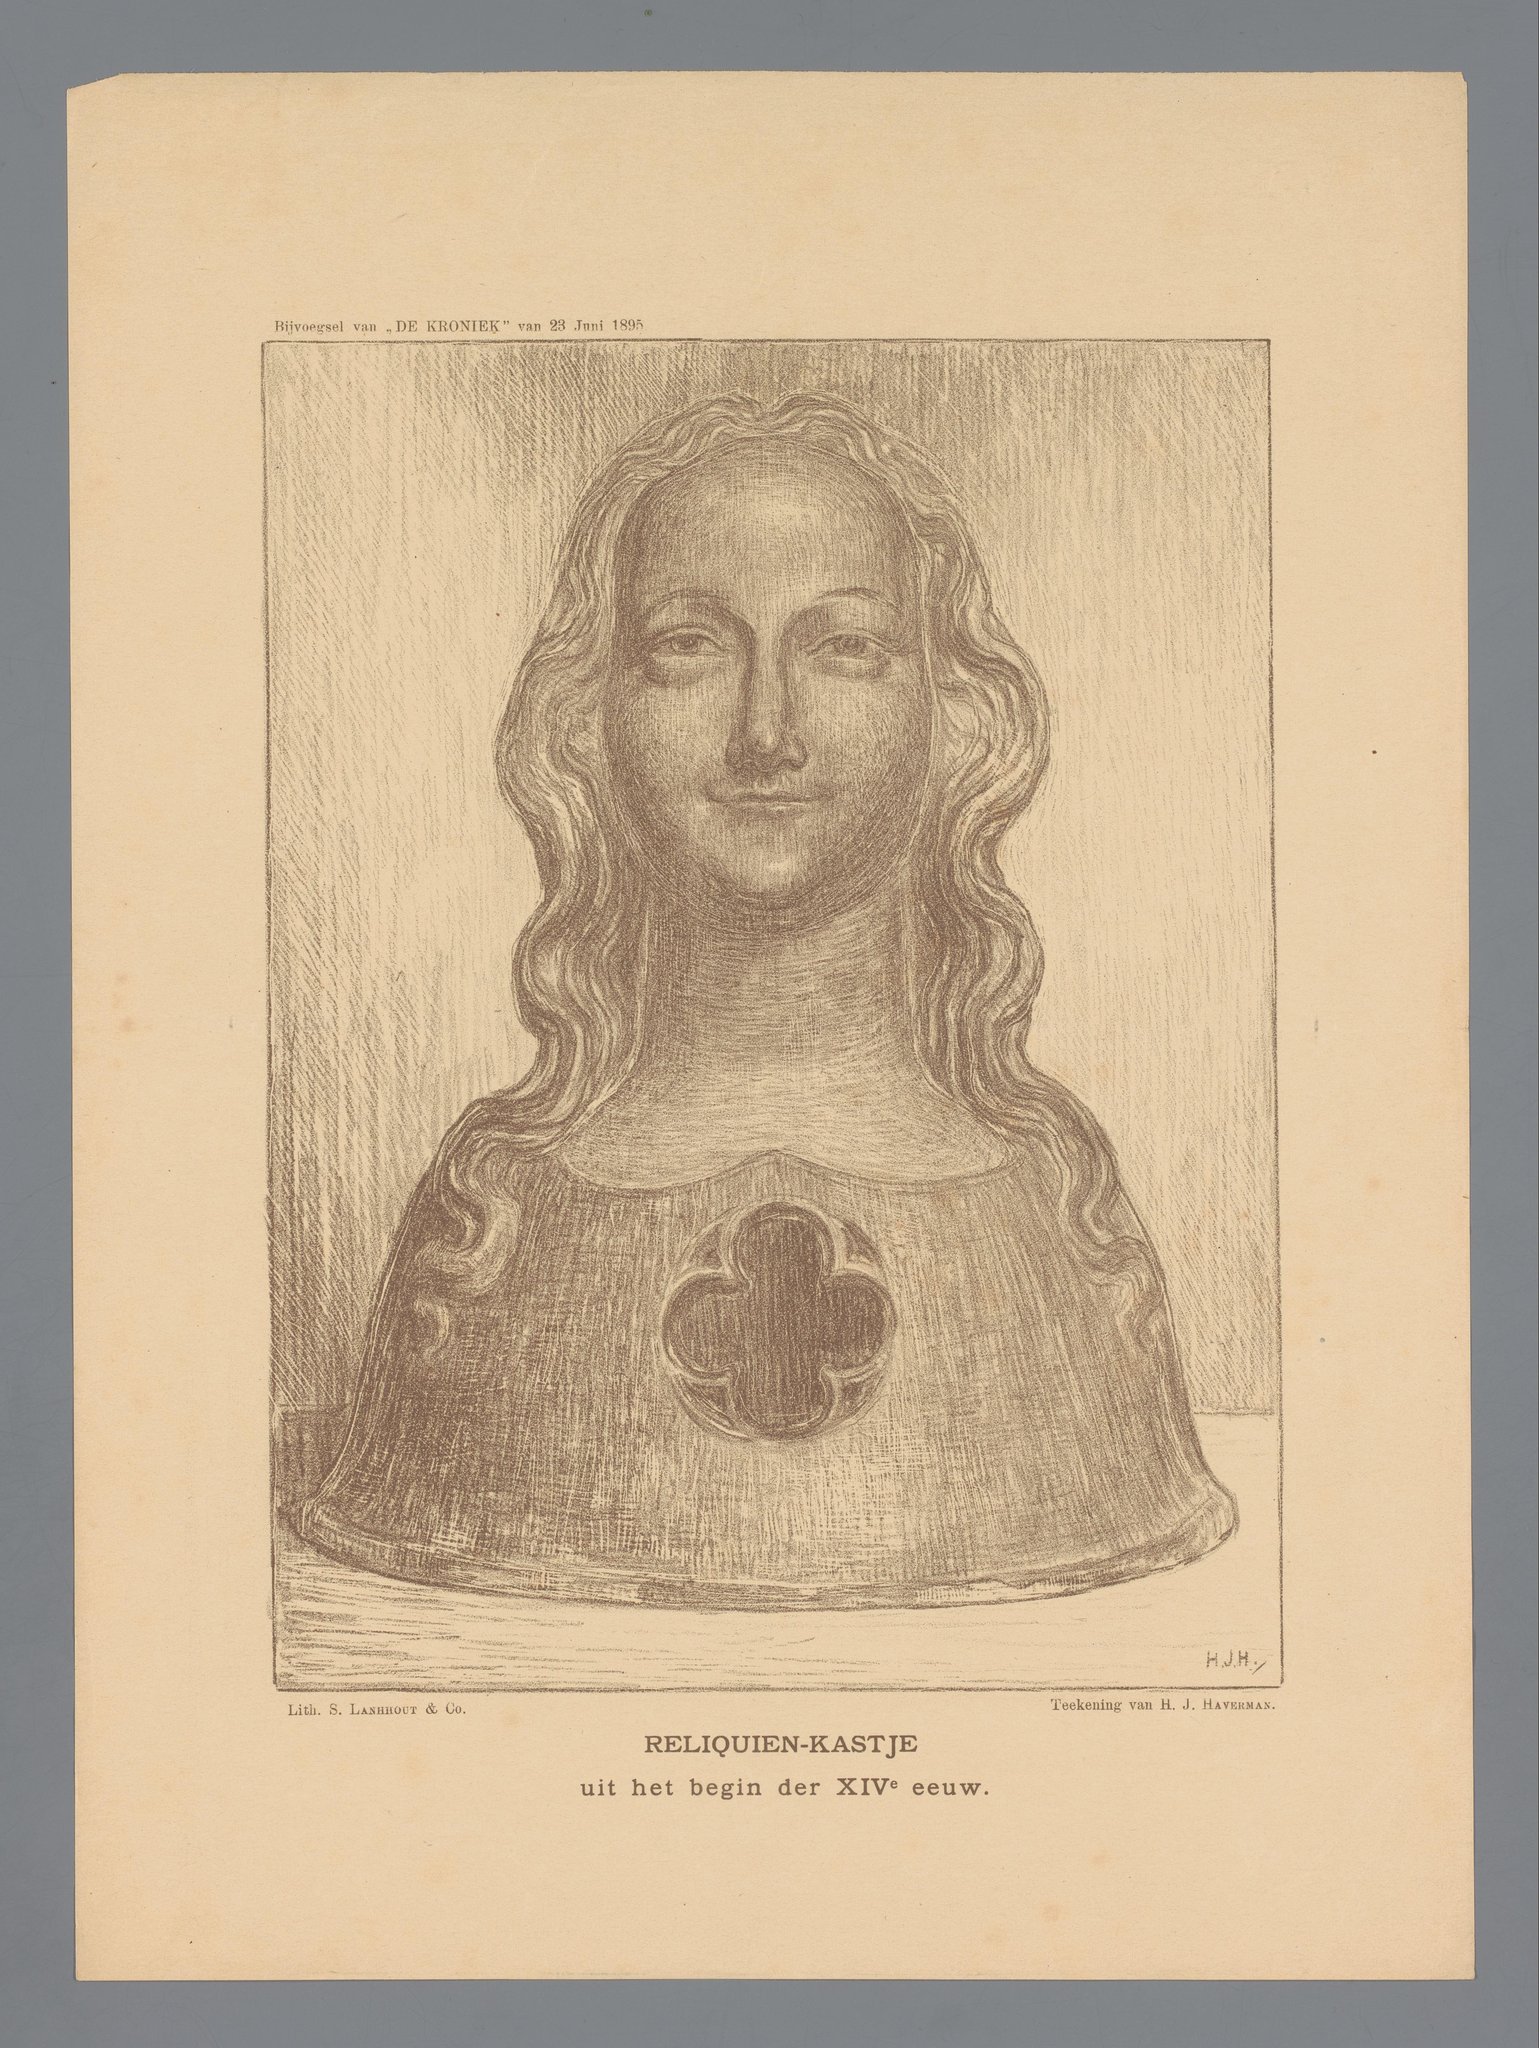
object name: print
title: Reliquien-kastje uit het begin der XIVde eeuw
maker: hendrik johannes haverman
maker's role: draughtsman, print maker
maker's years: 1857-1928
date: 1895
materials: paper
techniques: lithograph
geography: amsterdam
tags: relics (and reliquaries)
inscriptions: date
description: Prent met titel en onderschrift, bijvoegsel bij 'De Kroniek'. Gesigneerd en gedateerd.